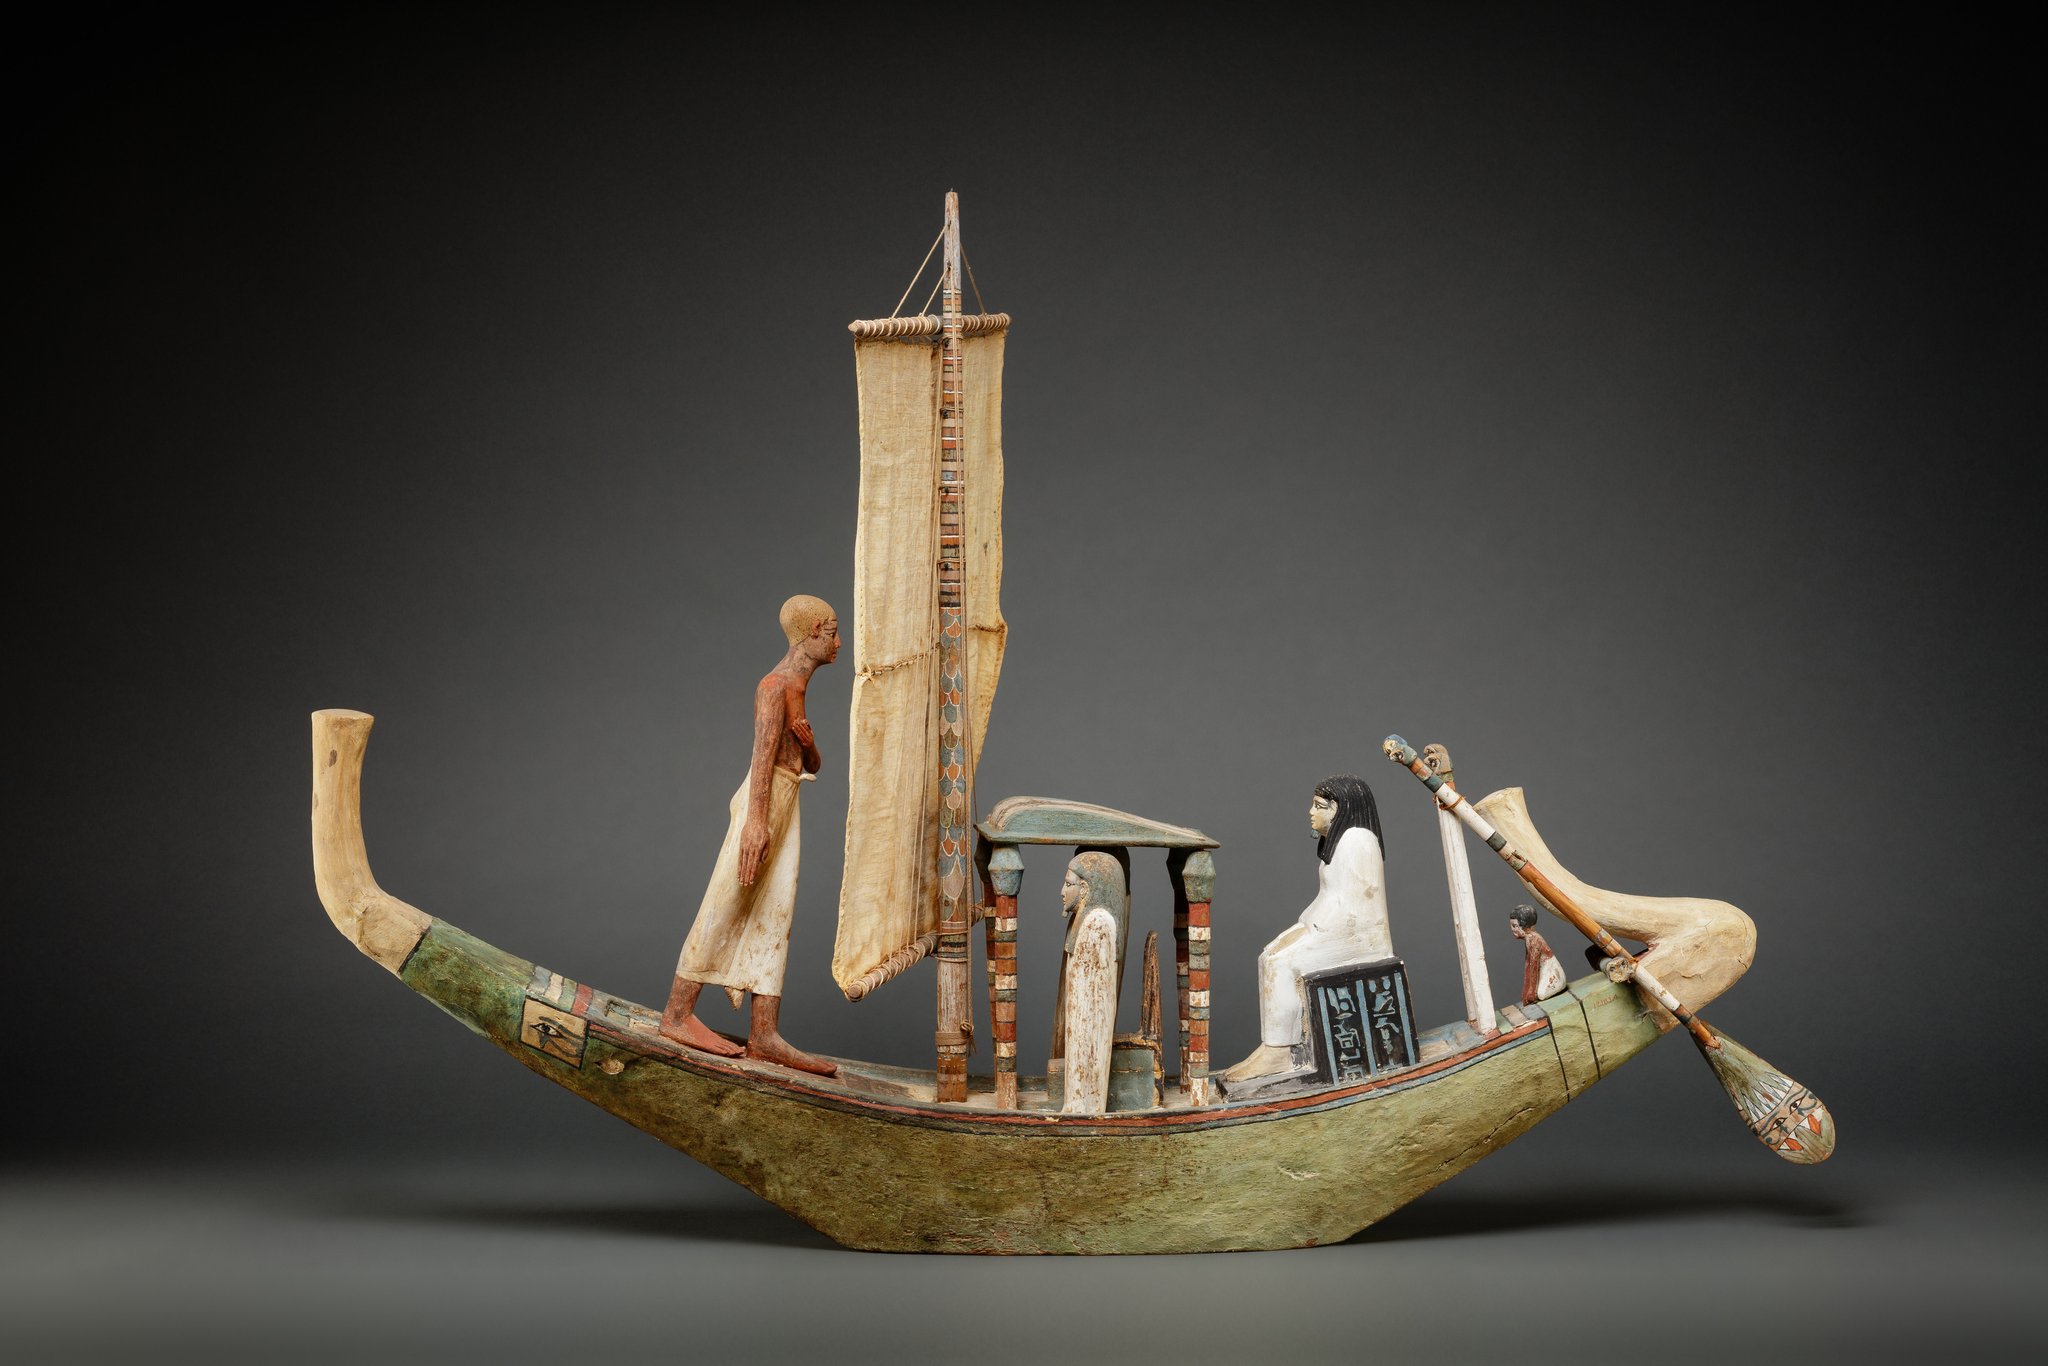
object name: model boat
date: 1981-1802 BCE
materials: linen, wood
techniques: painting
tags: men,women,boats